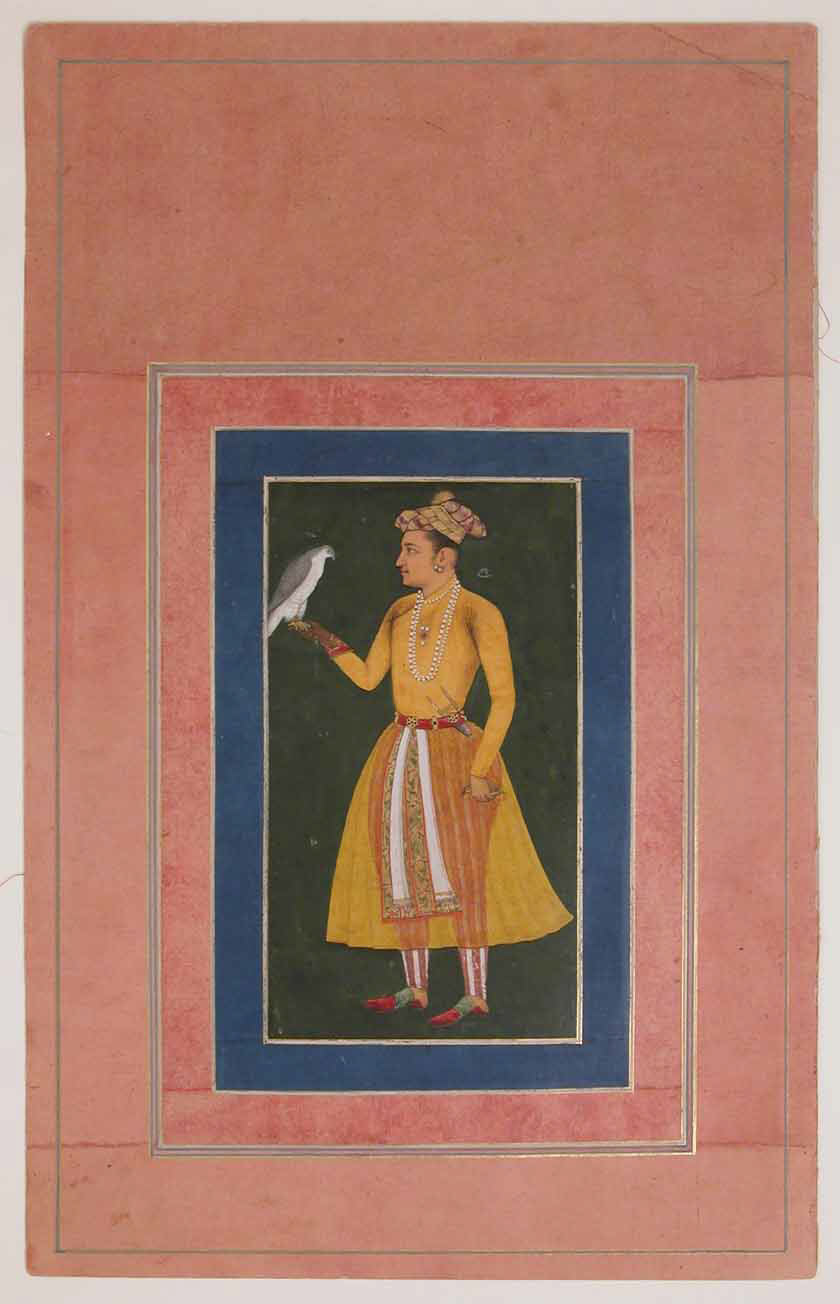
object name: illustrated album leaf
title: "Portrait of a Prince in Yellow Robe, Holding a Falcon", Folio from the Davis Album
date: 1601-1700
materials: gold, ink, paper, watercolor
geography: india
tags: falcons,princes,portraits